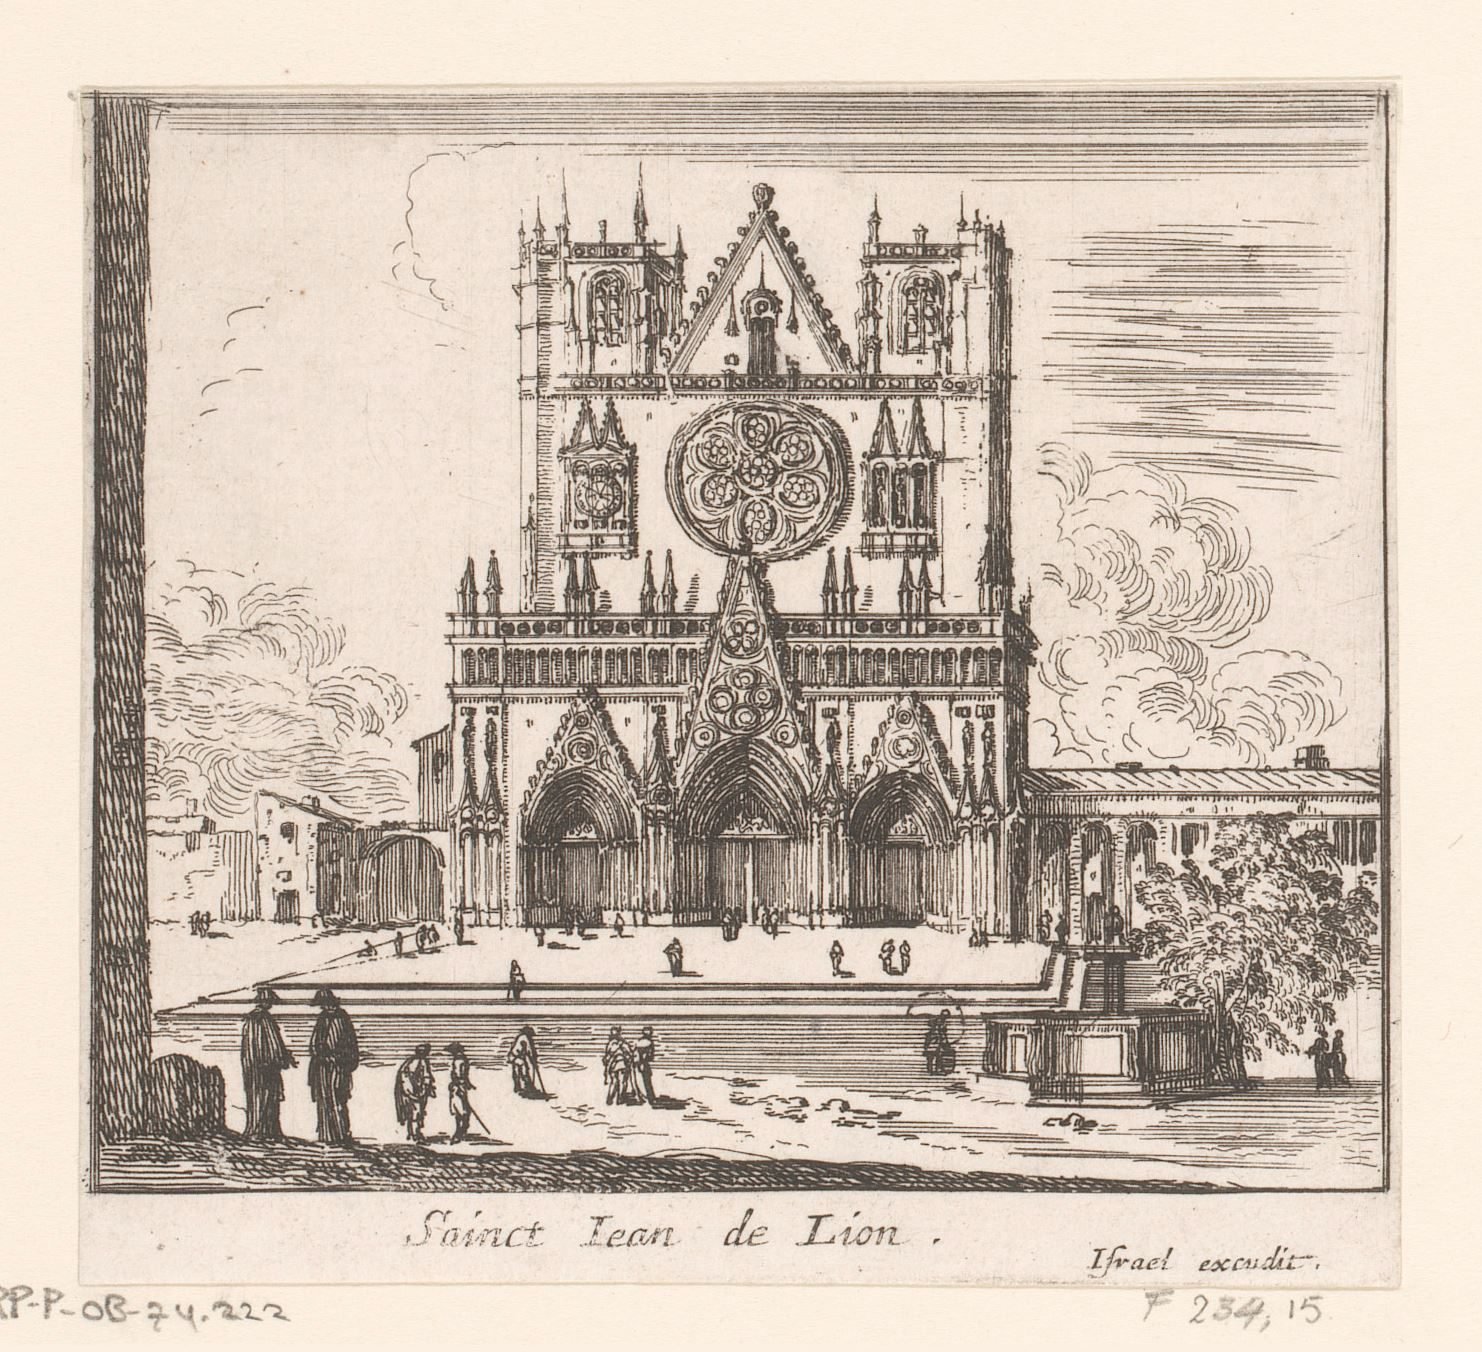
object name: print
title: Sainct Jean de Lion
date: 1652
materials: paper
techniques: engraving, etching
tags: city-view, and landscape with man-made constructions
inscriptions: collector's mark: Lugt 240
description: Prent maakt deel uit van een ongenummerde serie van dertien prenten.